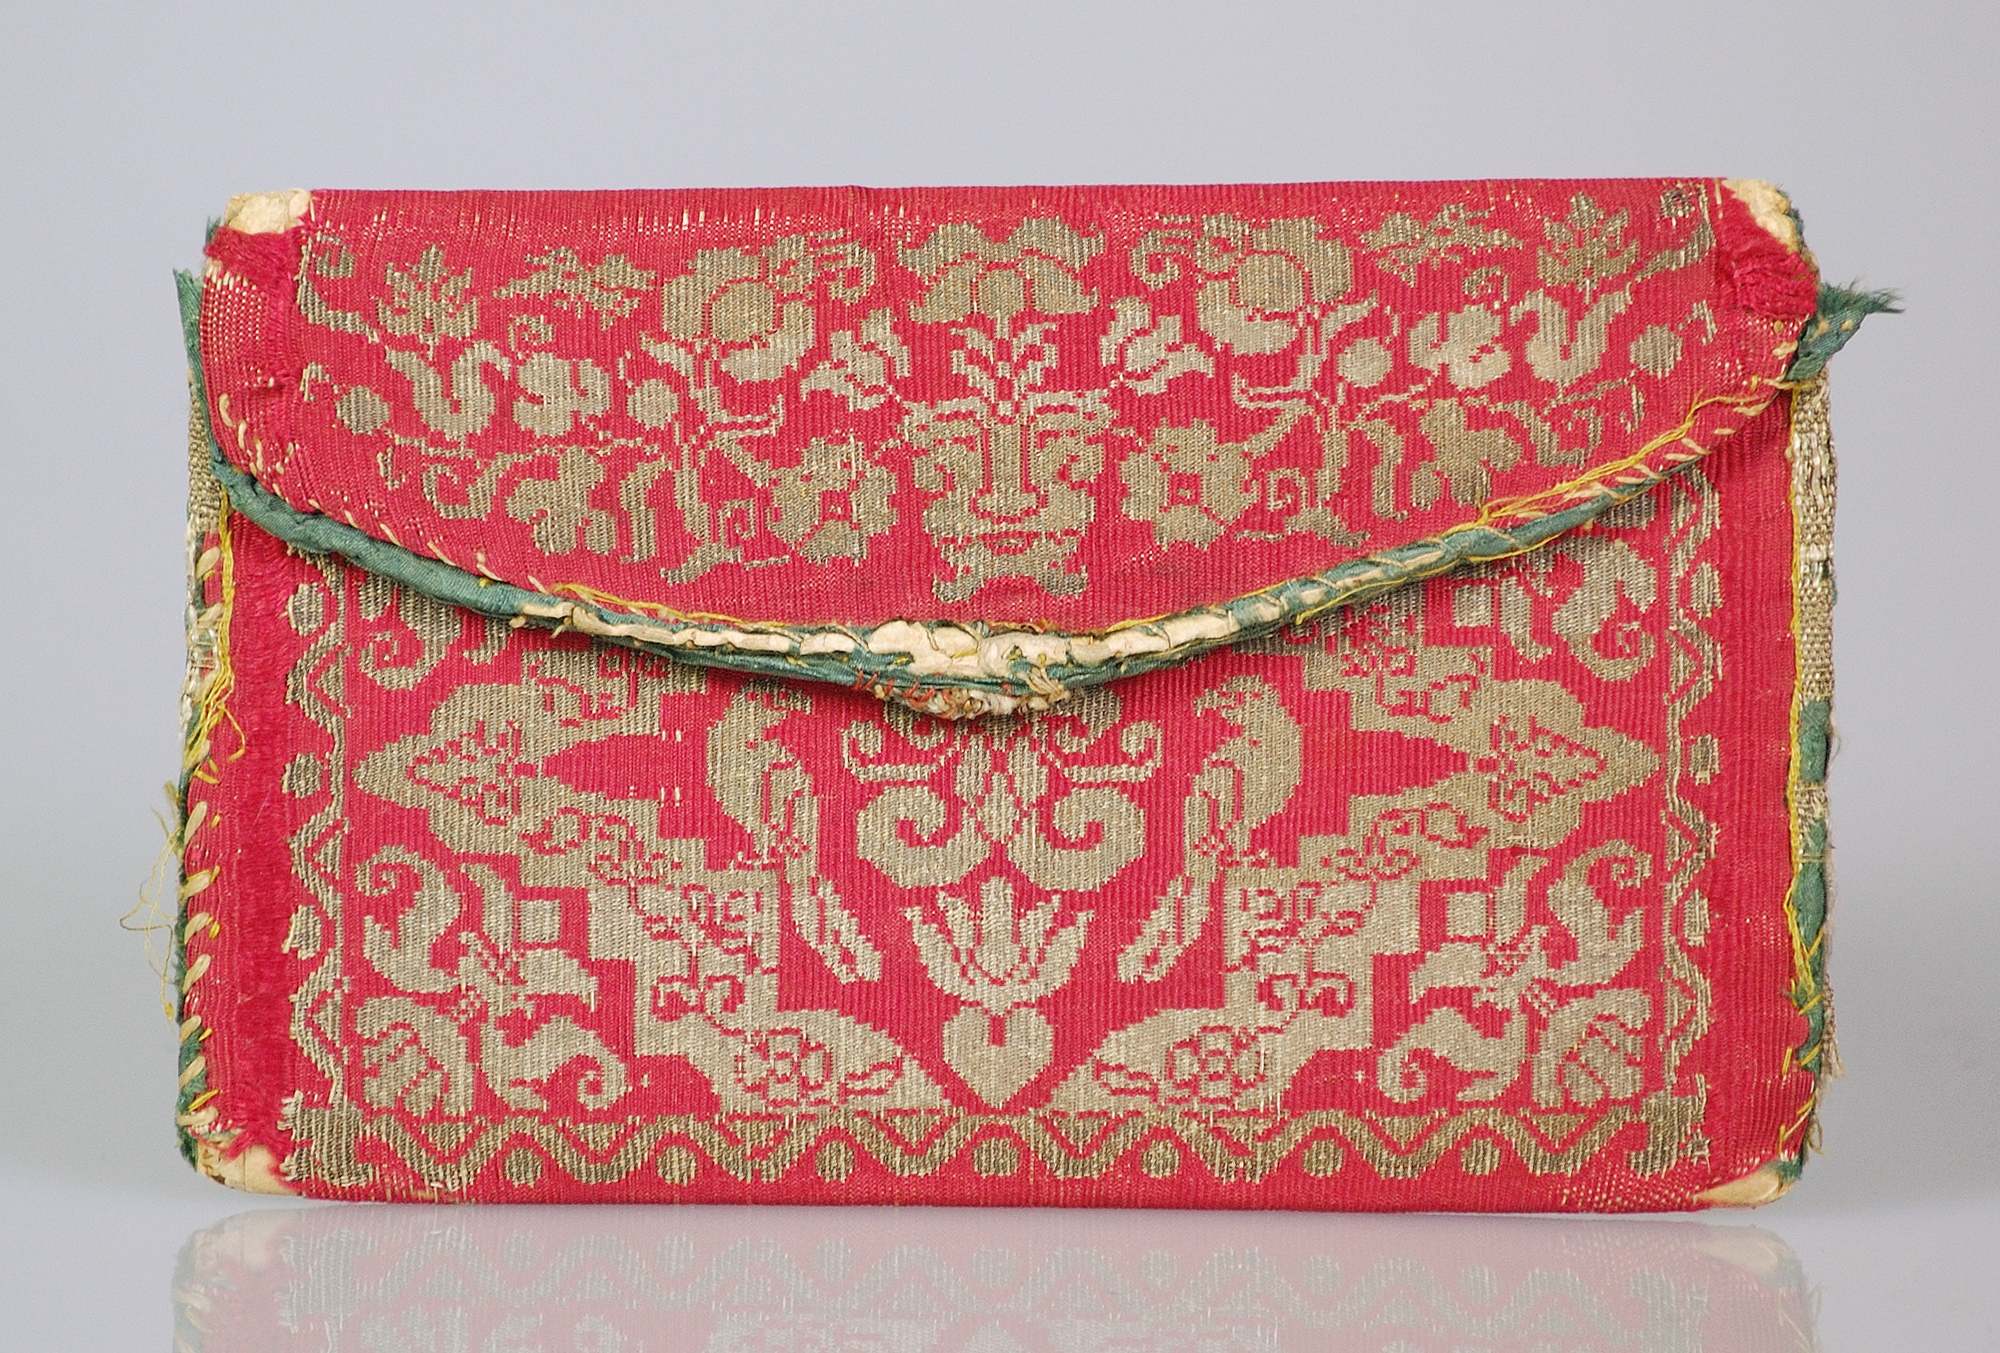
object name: bag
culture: european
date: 1701-1725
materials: metal, silk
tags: birds